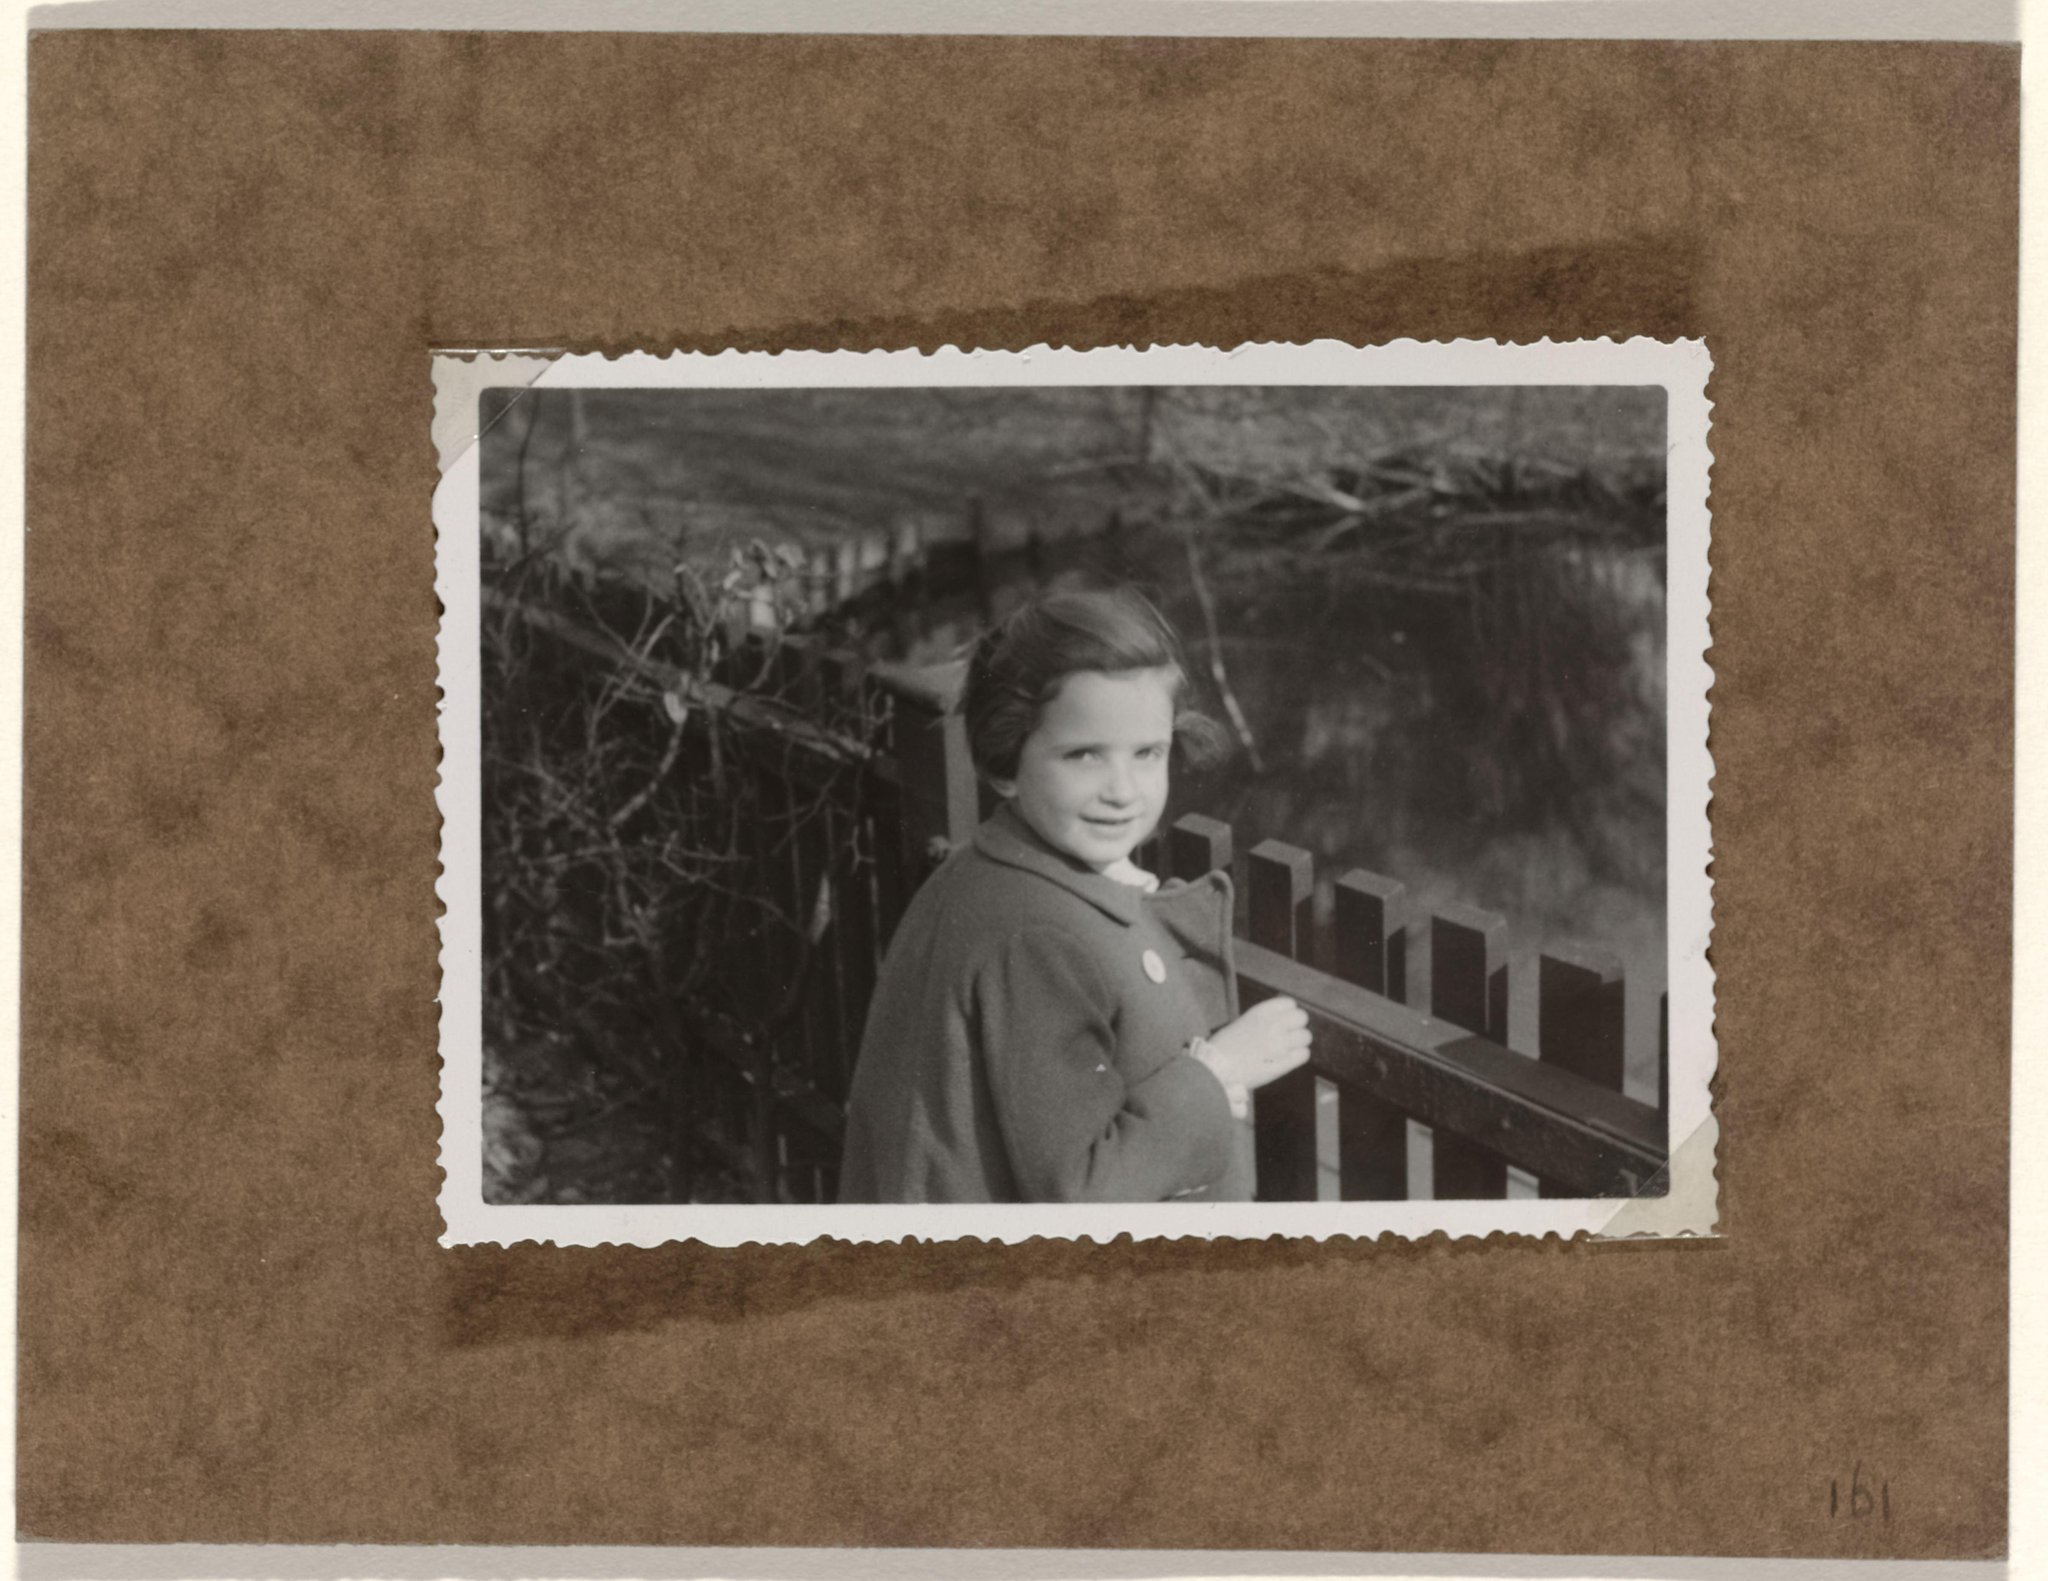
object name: photograph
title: Isabel Wachenheimer in de tuin van de woning van Willy Moos, Bellevue 62, Hamburg, maart-april 1935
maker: Anonymous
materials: photographic support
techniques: gelatin silver print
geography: hamburg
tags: leiden, isabel wachenheimer-elon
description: Isabel Wachenheimer in de tuin van de woning van Willy Moos, Bellevue 62.